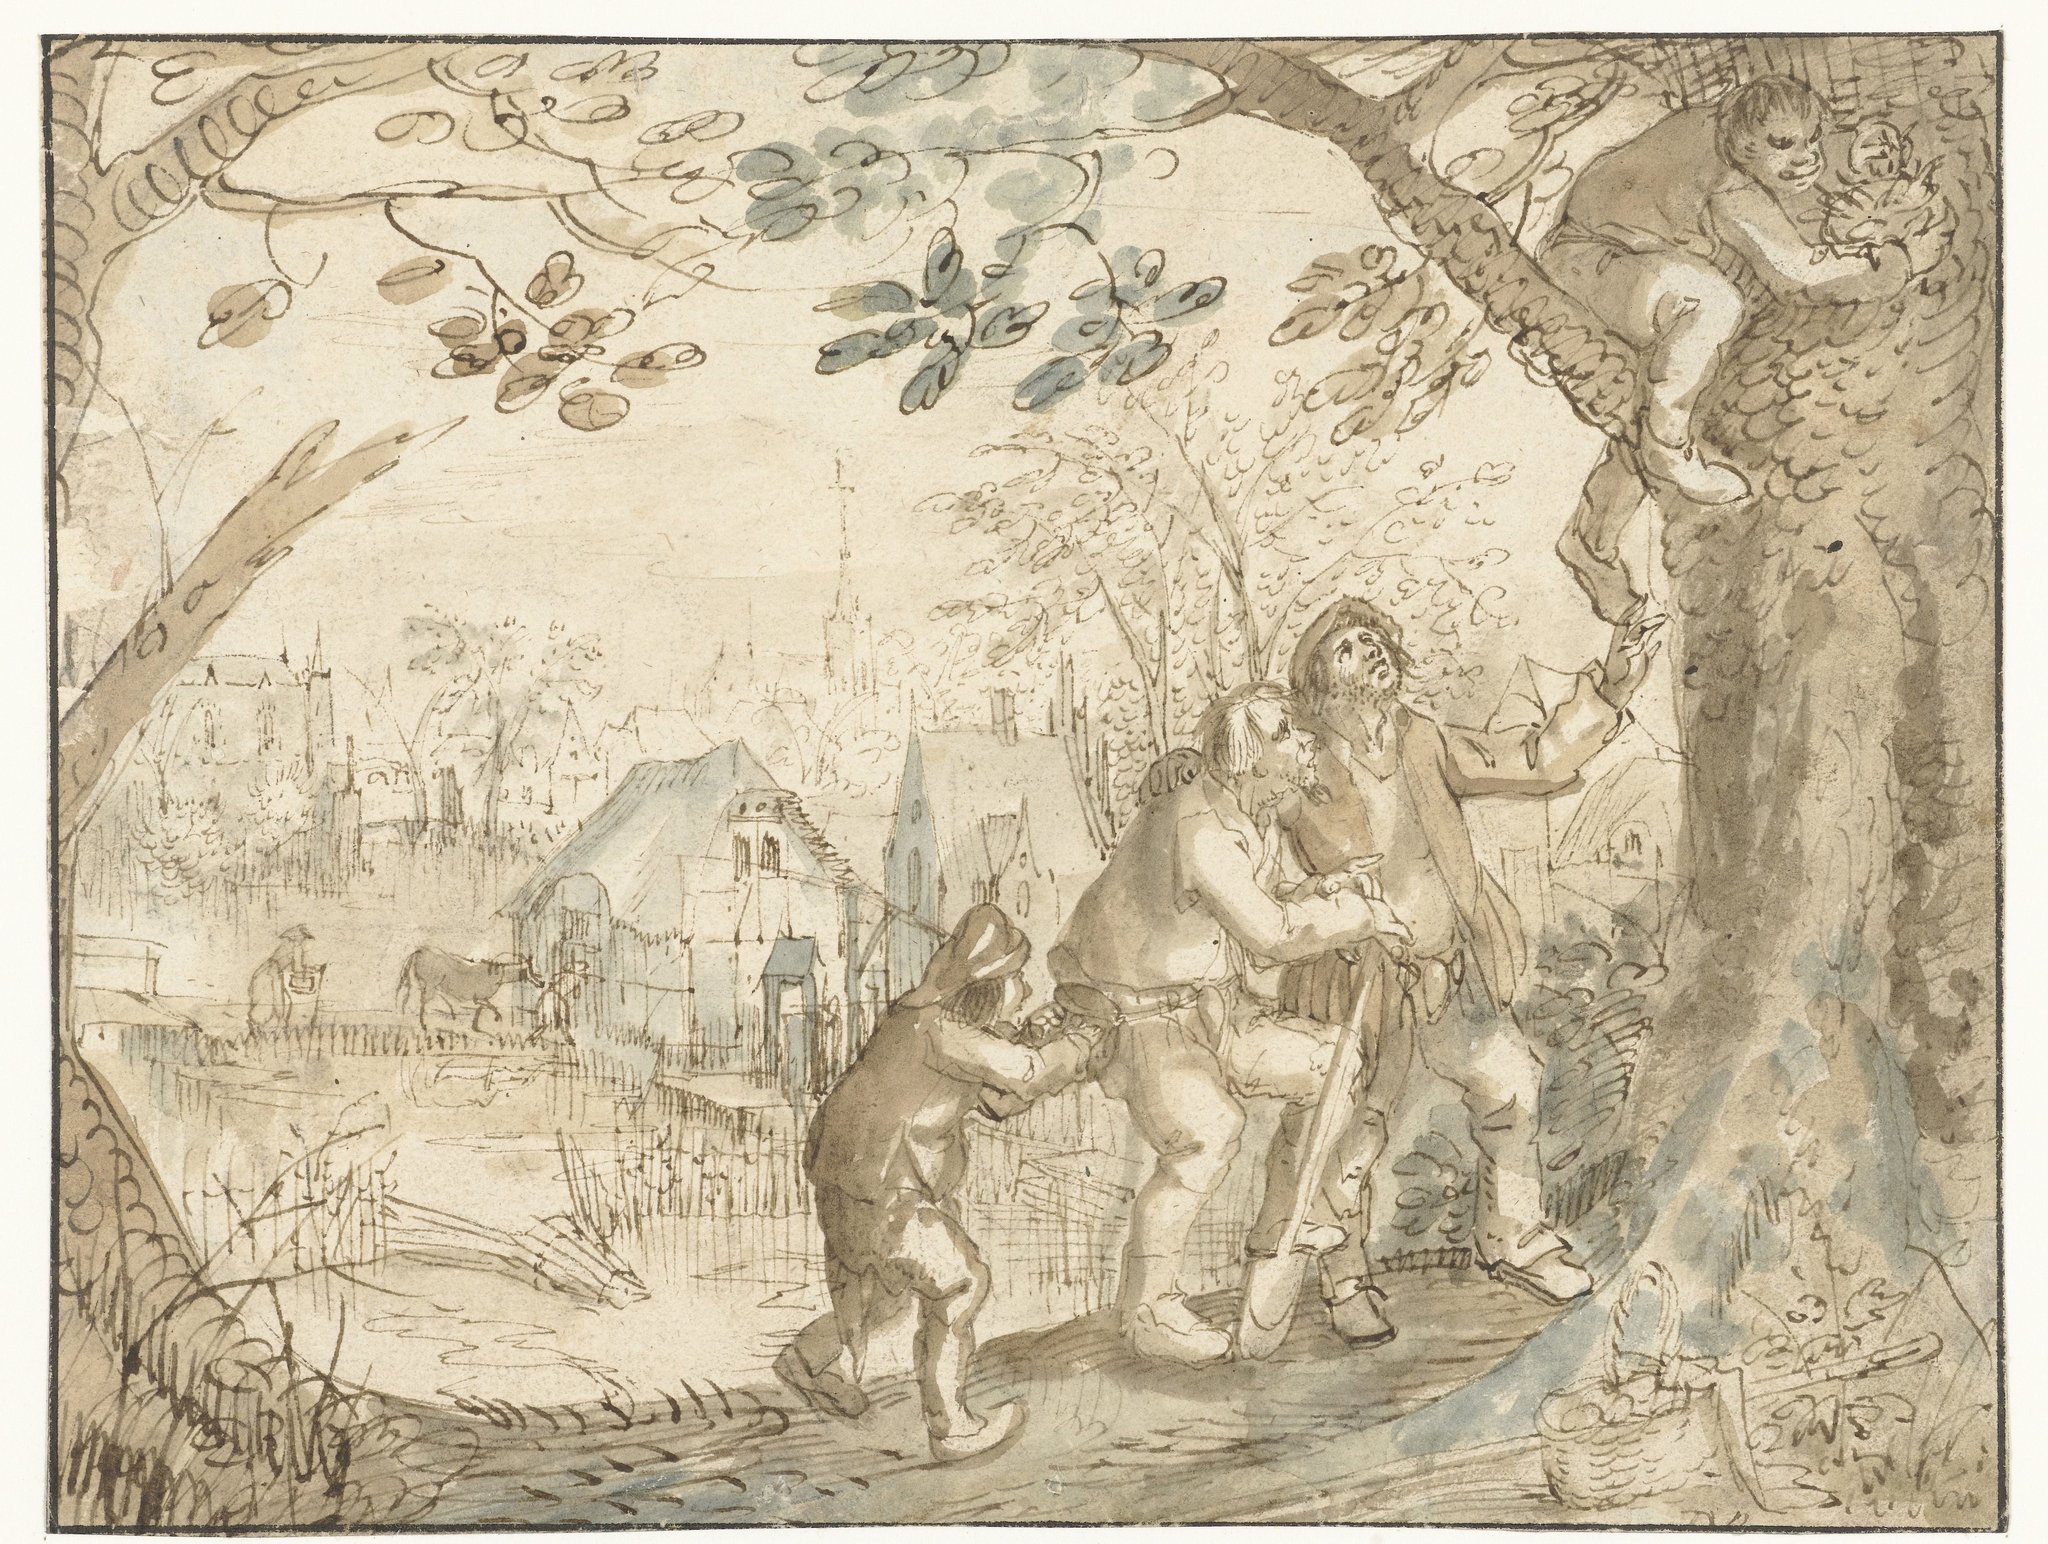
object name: drawing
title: The Bird-Nester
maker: david vinckboons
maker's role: draughtsman, painter, print maker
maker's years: 1576-1629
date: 1604-1606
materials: ink, paper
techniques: brush, pen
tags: child robbing bird's nests, proverbs, sayings, etc.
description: A lad steals eggs from a nest. Two peasants watch him closely, so intently in fact that they are oblivious to the boy cutting one of their purses. The depiction may have an erotic significance: whoever stands by idly, will not go far in love. The fish trap in the water could also refer to courtship and marriage.